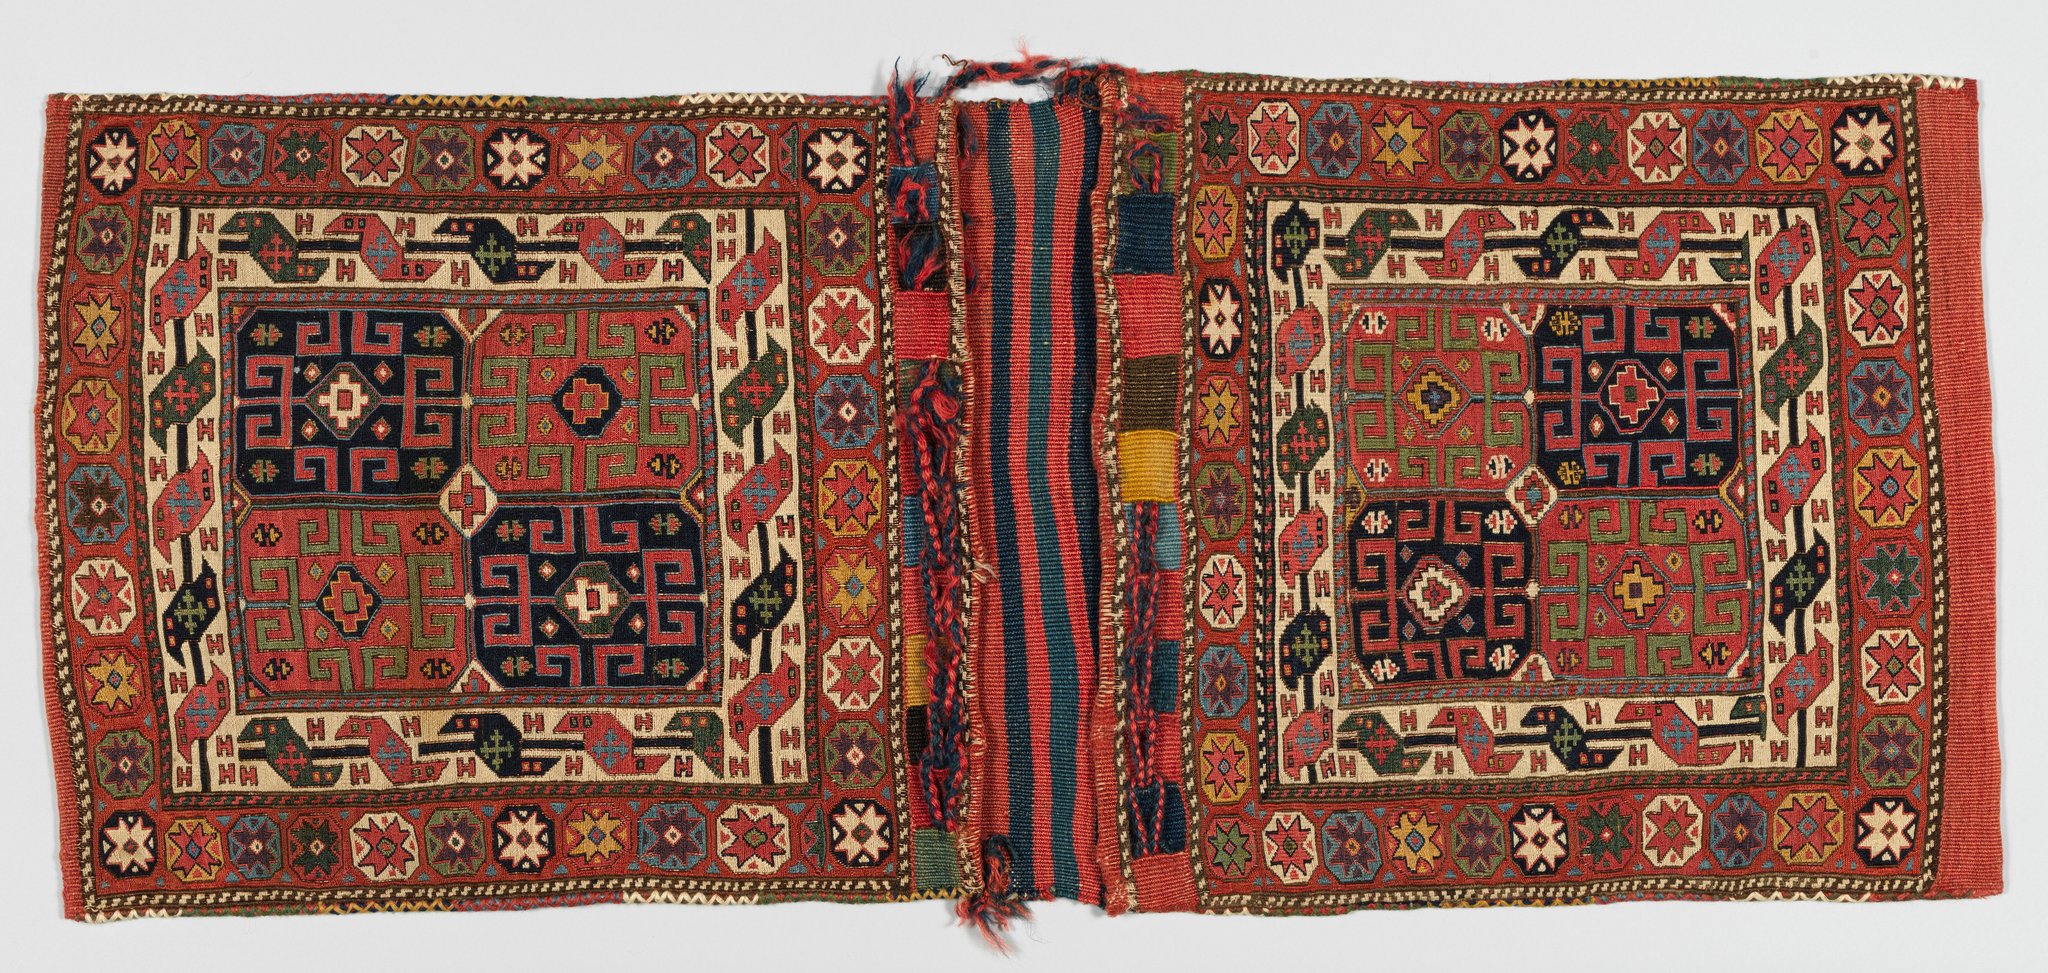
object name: saddle bag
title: Shahsevan Double Saddle Bag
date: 1860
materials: wool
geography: iran